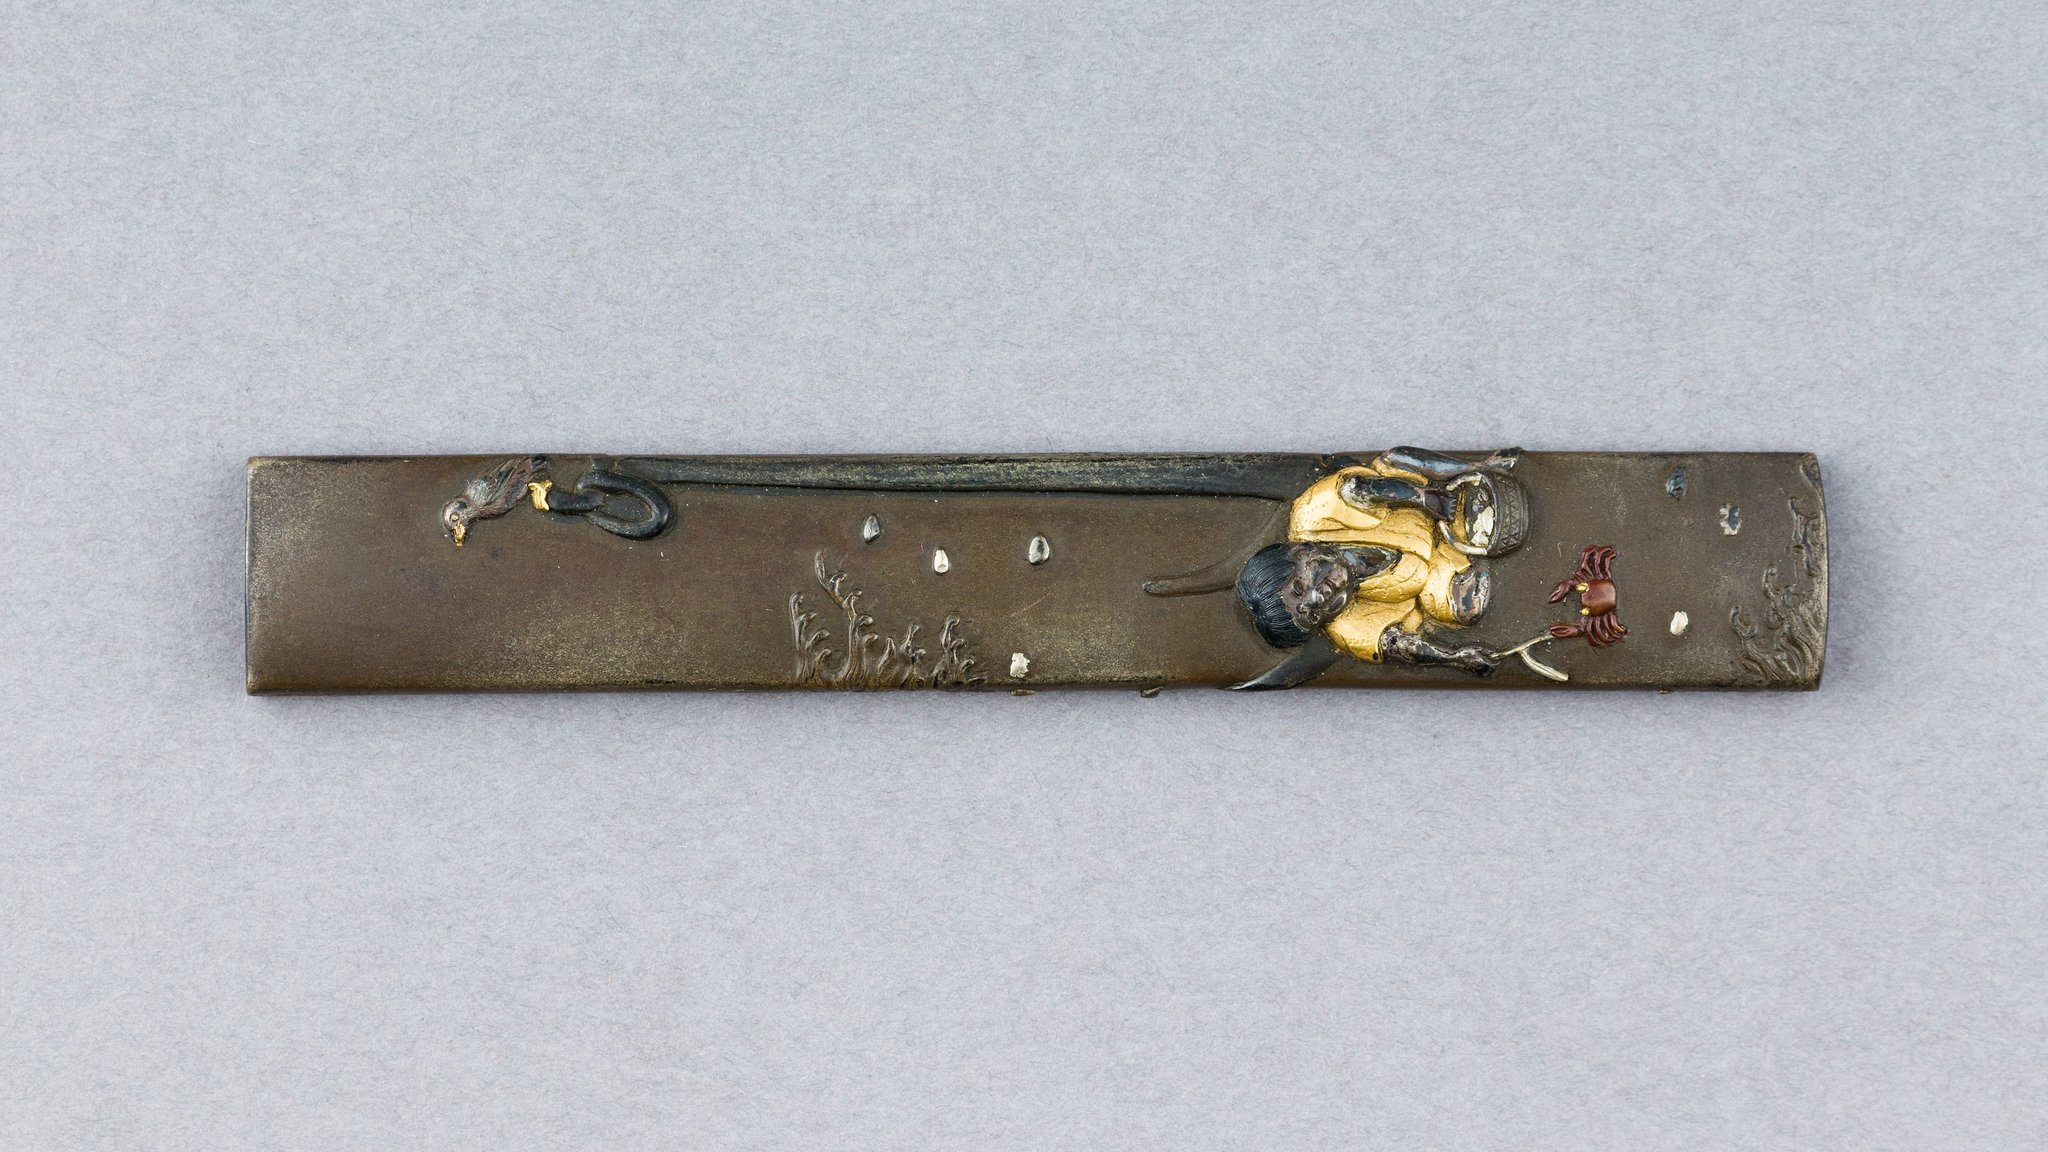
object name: knife handle kozuka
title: Knife Handle (Kozuka)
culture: japanese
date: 1615-1868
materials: copper, gold alloy, silver alloy, gold, silver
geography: japan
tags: human figures,birds,crabs